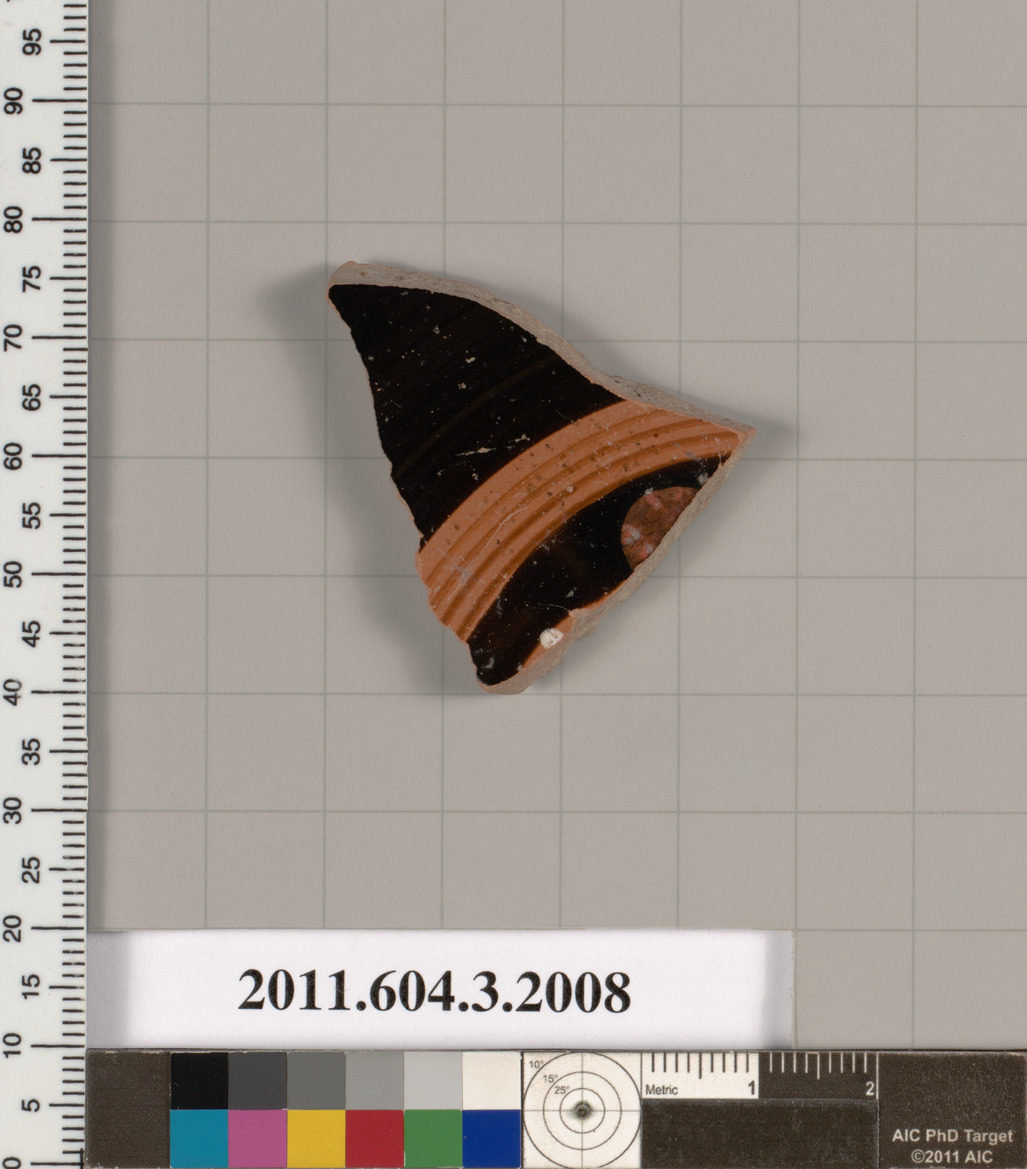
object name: kylix fragment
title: Terracotta fragment of a kylix (drinking cup)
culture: greek, attic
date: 550-526 BCE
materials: terracotta